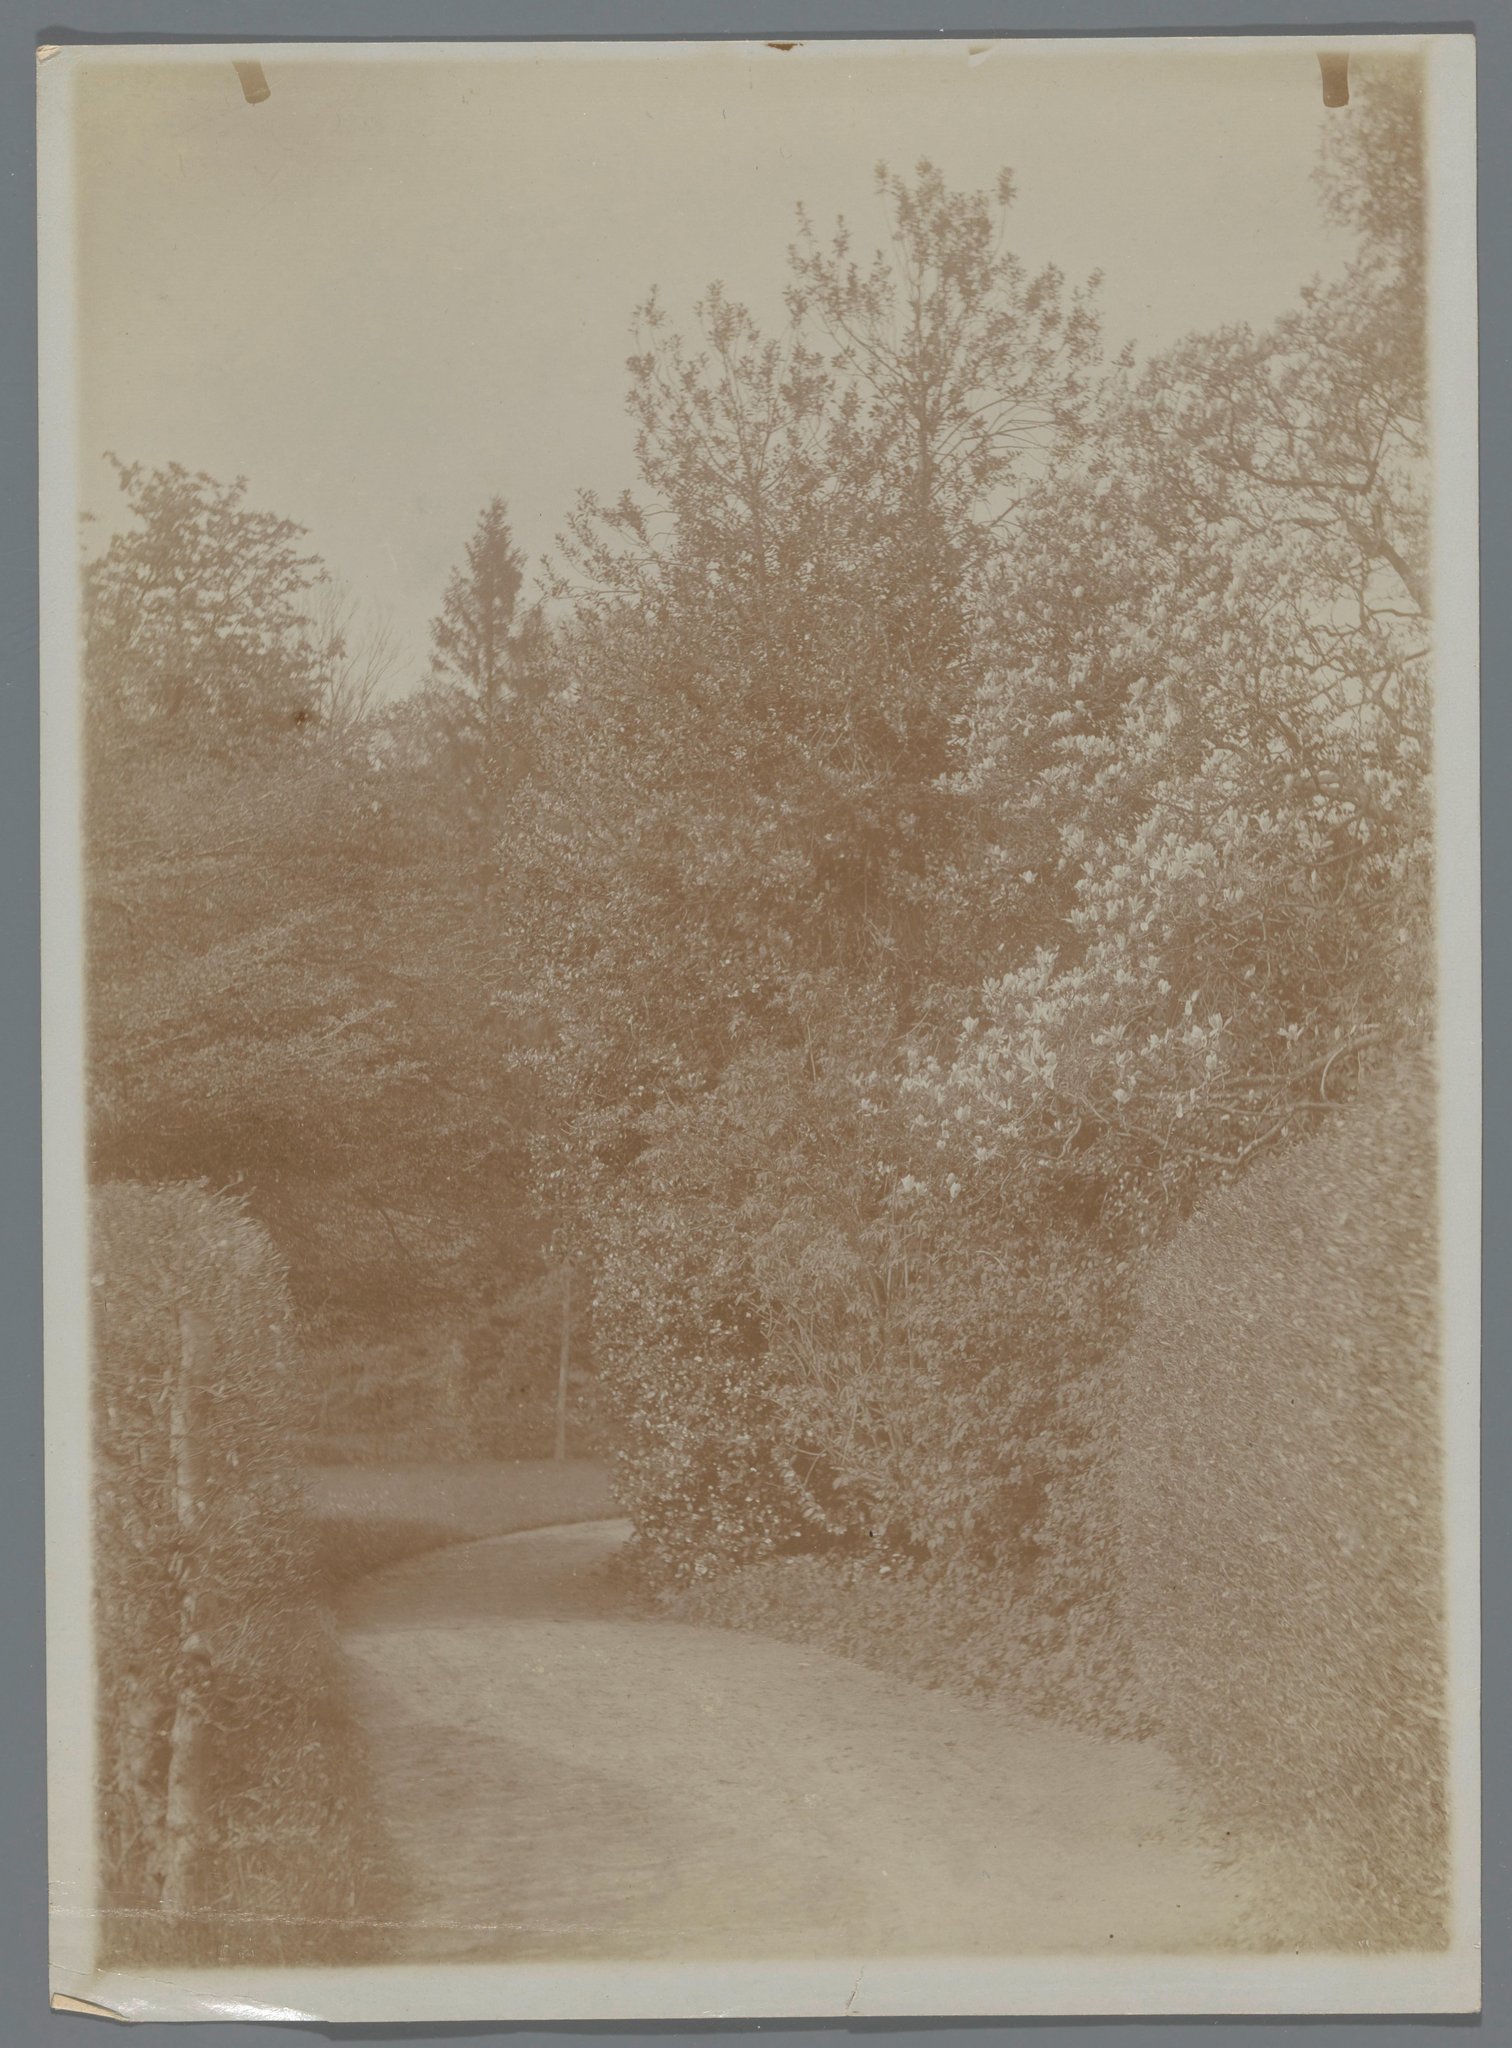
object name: photograph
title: Gezicht op de tuin bij buitenplaats Rustenhoven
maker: cornelia hendrika jonker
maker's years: 1874-1924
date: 1880-1920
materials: photographic support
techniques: collodion silver print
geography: maartensdijk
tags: trees, garden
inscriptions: annotation: ‘Rustenhoven’